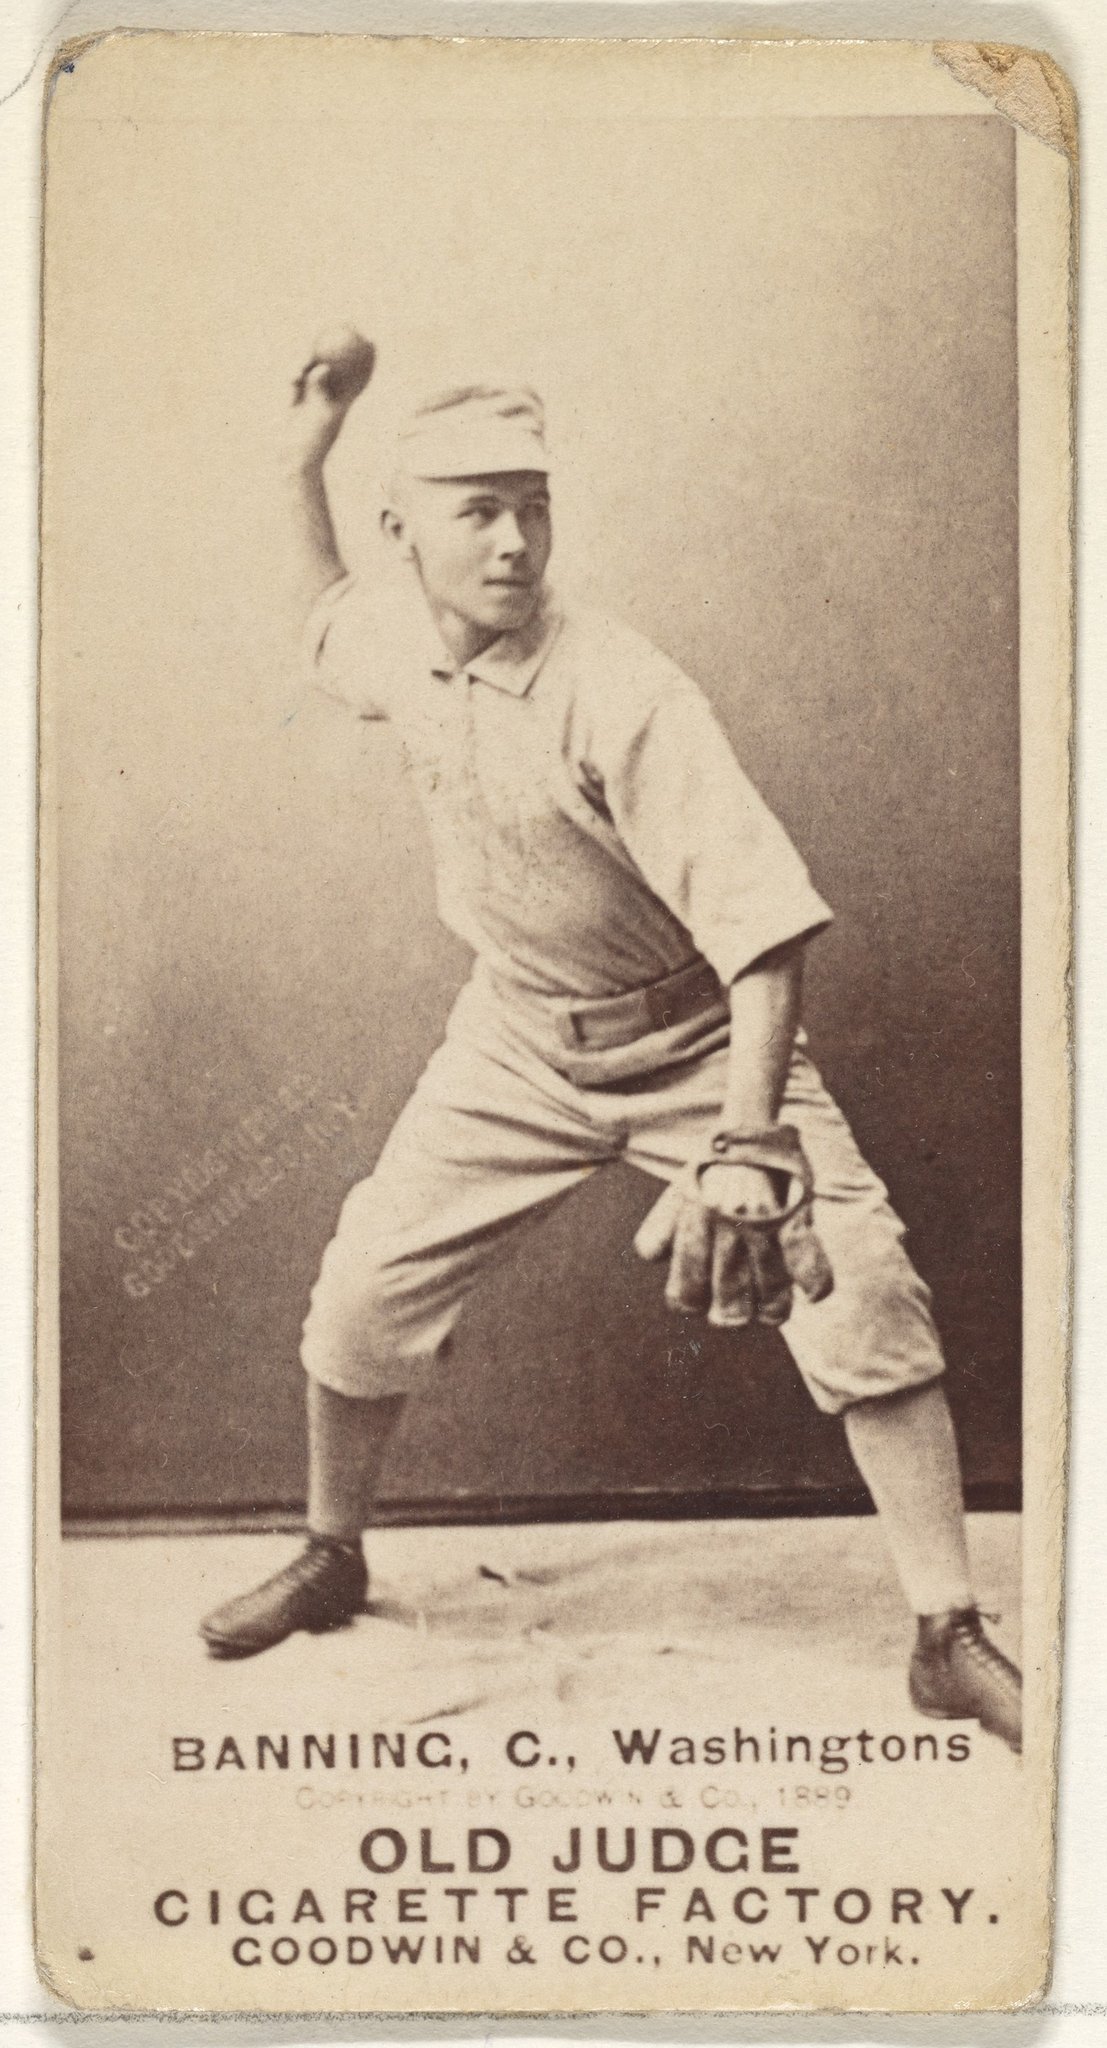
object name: baseball card, photograph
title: James "Jim" M. Banning, Catcher, Washington Nationals, from the Old Judge series (N172) for Old Judge Cigarettes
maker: goodwin & company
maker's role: publisher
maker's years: 1850-1950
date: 1889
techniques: albumen silver print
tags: men,portraits,baseball,athletes